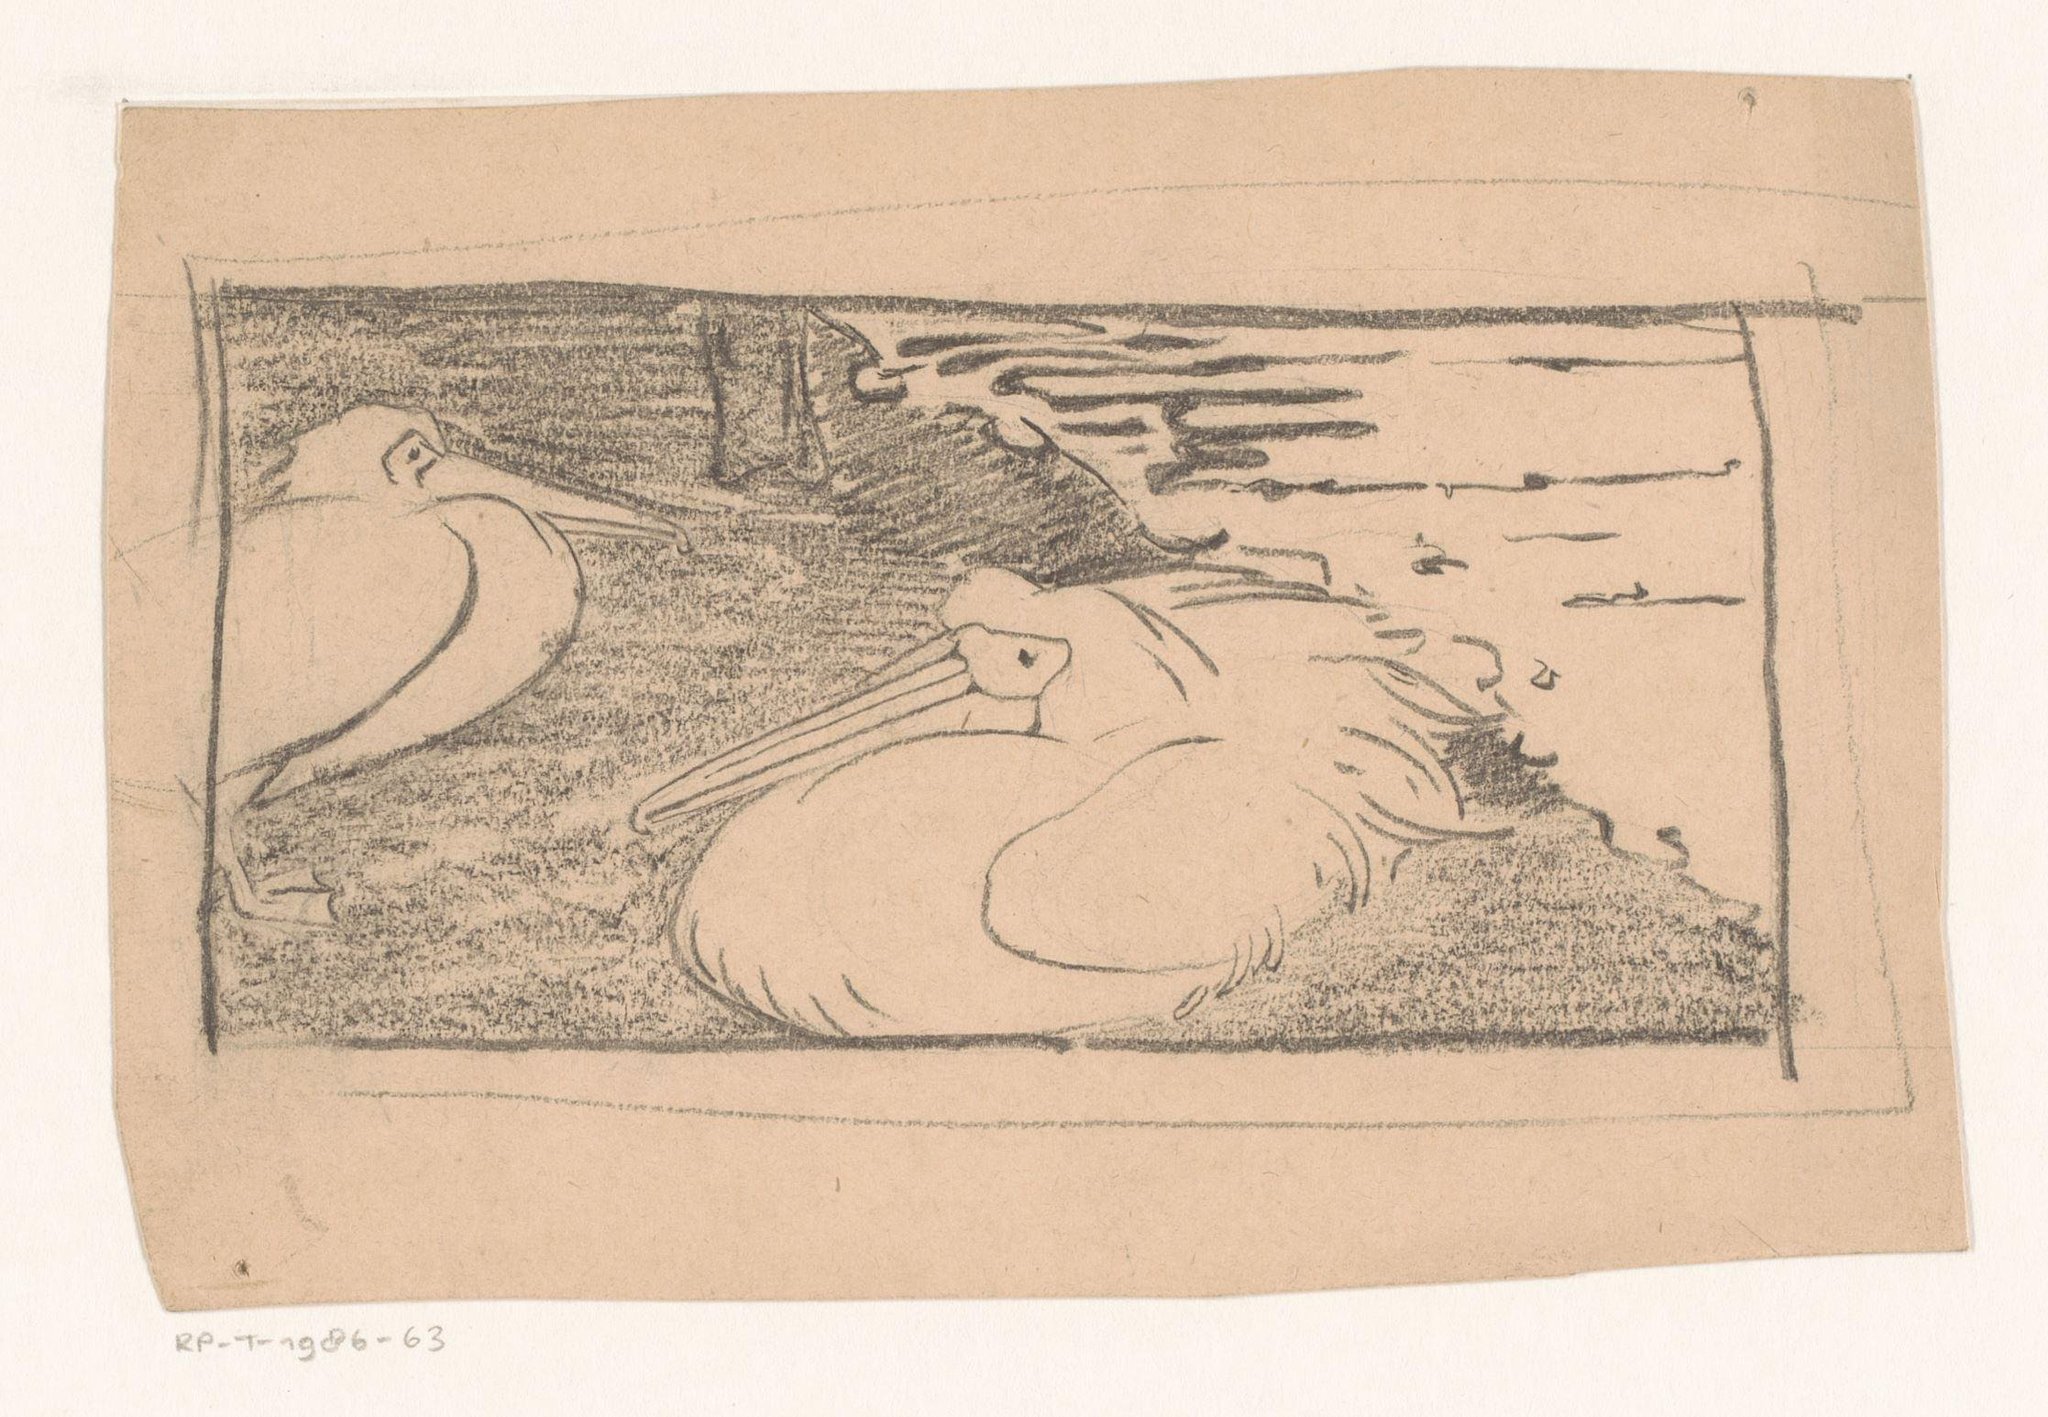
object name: drawing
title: Twee pelikanen aan de waterkant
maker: reinier willem petrus de vries (1874-1953)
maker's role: draughtsman, print maker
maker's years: 1874-1953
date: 1884-1952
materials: chalk, paper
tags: water-birds: pelican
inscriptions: collector's mark: ‘R:MVS.’